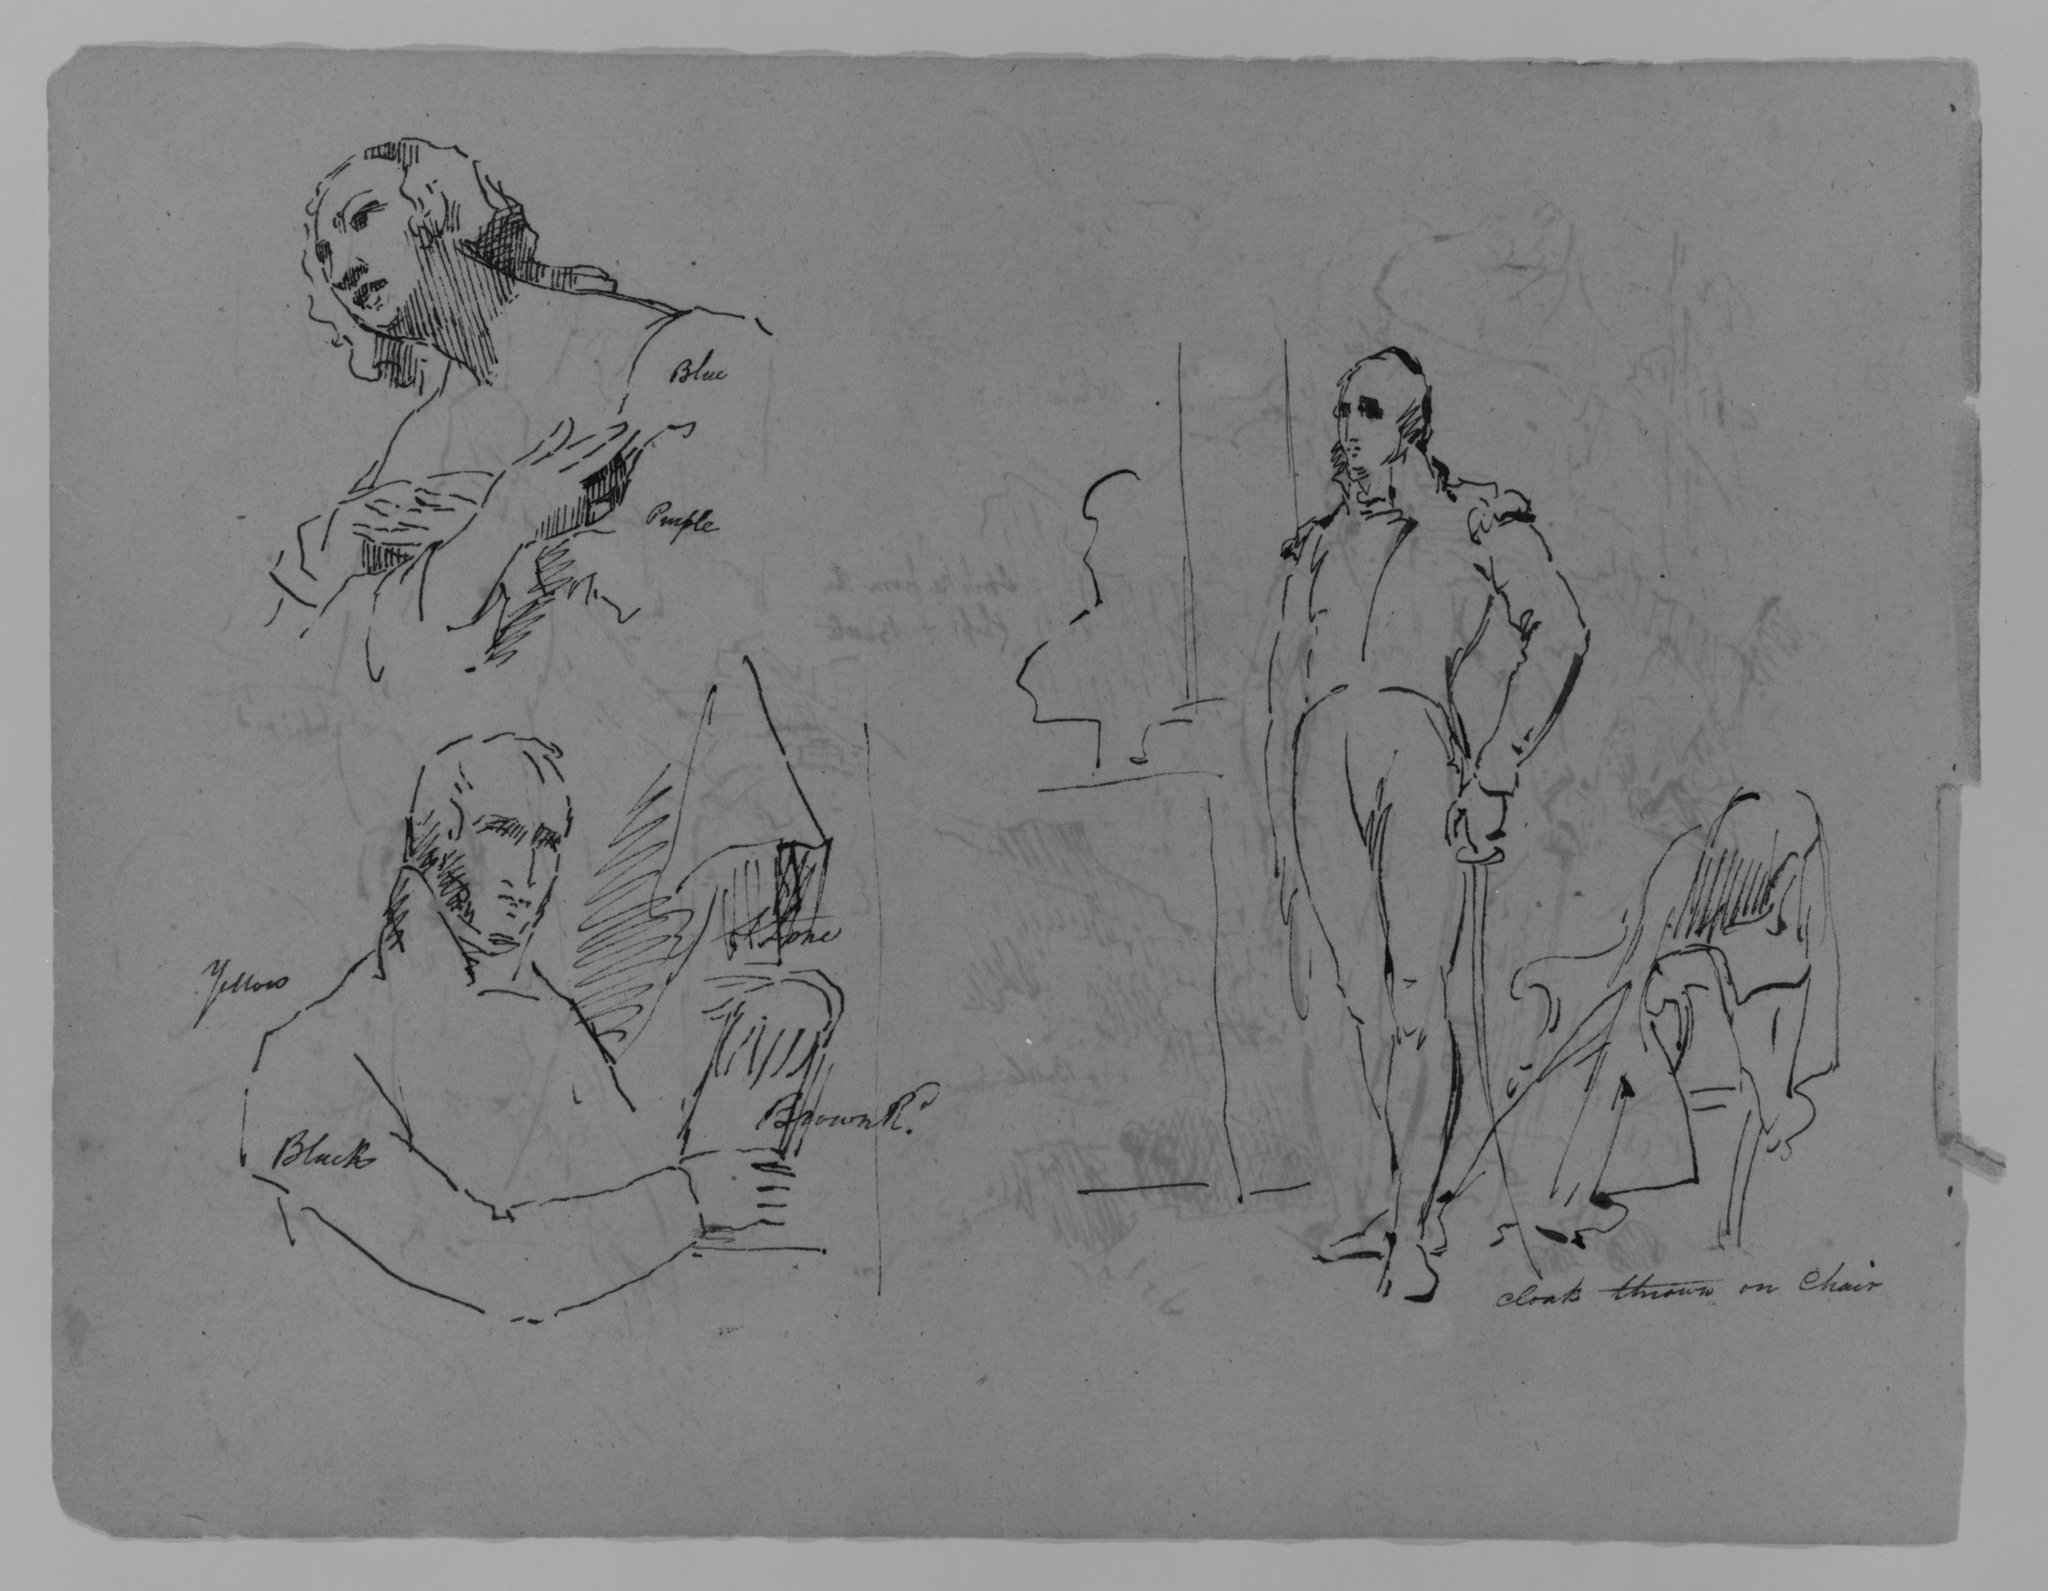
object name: drawing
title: (From Sketchbook)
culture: american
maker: thomas sully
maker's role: artist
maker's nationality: american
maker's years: 1783-1872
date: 1810-1820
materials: ink, paper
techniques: wash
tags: men,women